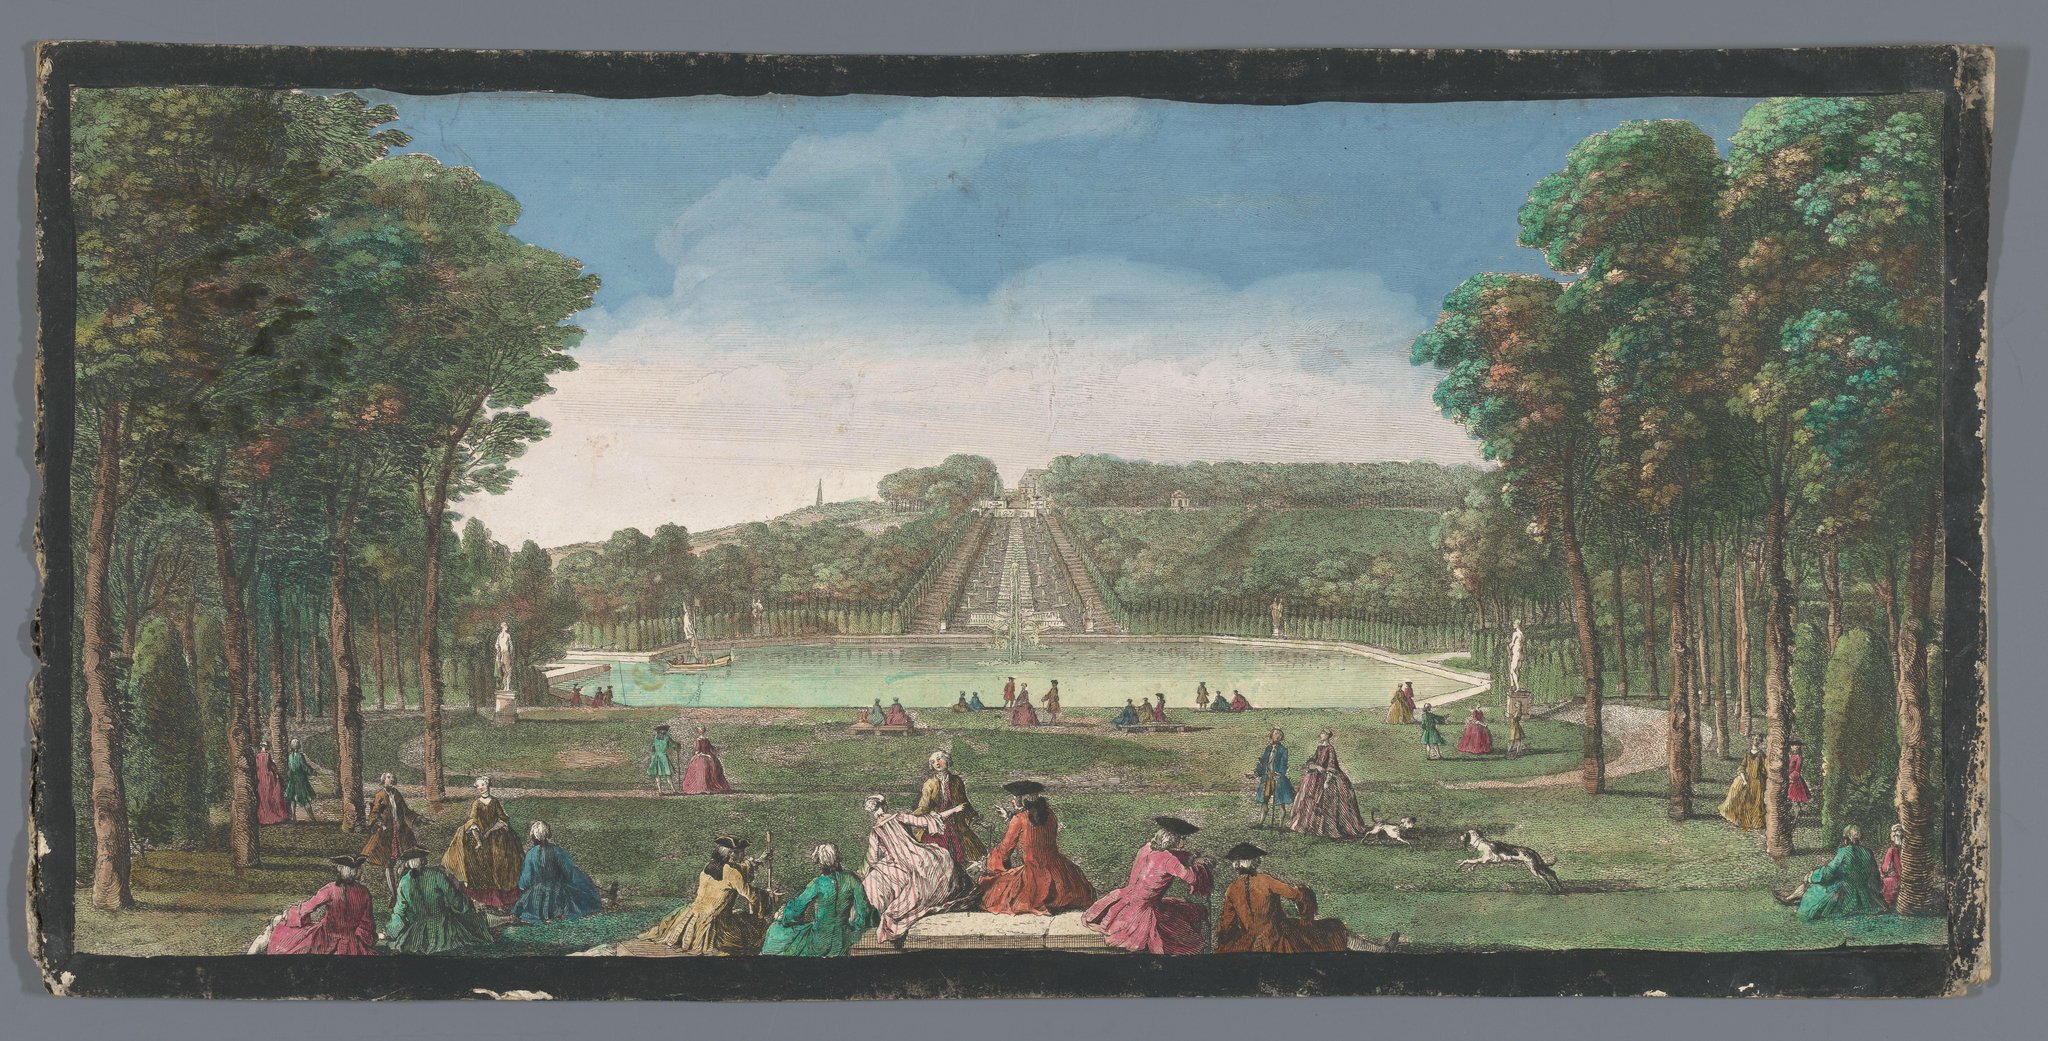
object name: opticaprent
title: Gezicht op de cascades van de tuin van het Château de Sceaux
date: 1700-1799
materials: cardboard, paper, watercolor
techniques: brush, etching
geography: paris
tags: garden, garden fountain, ornamental plants, garden ornaments, garden cascade